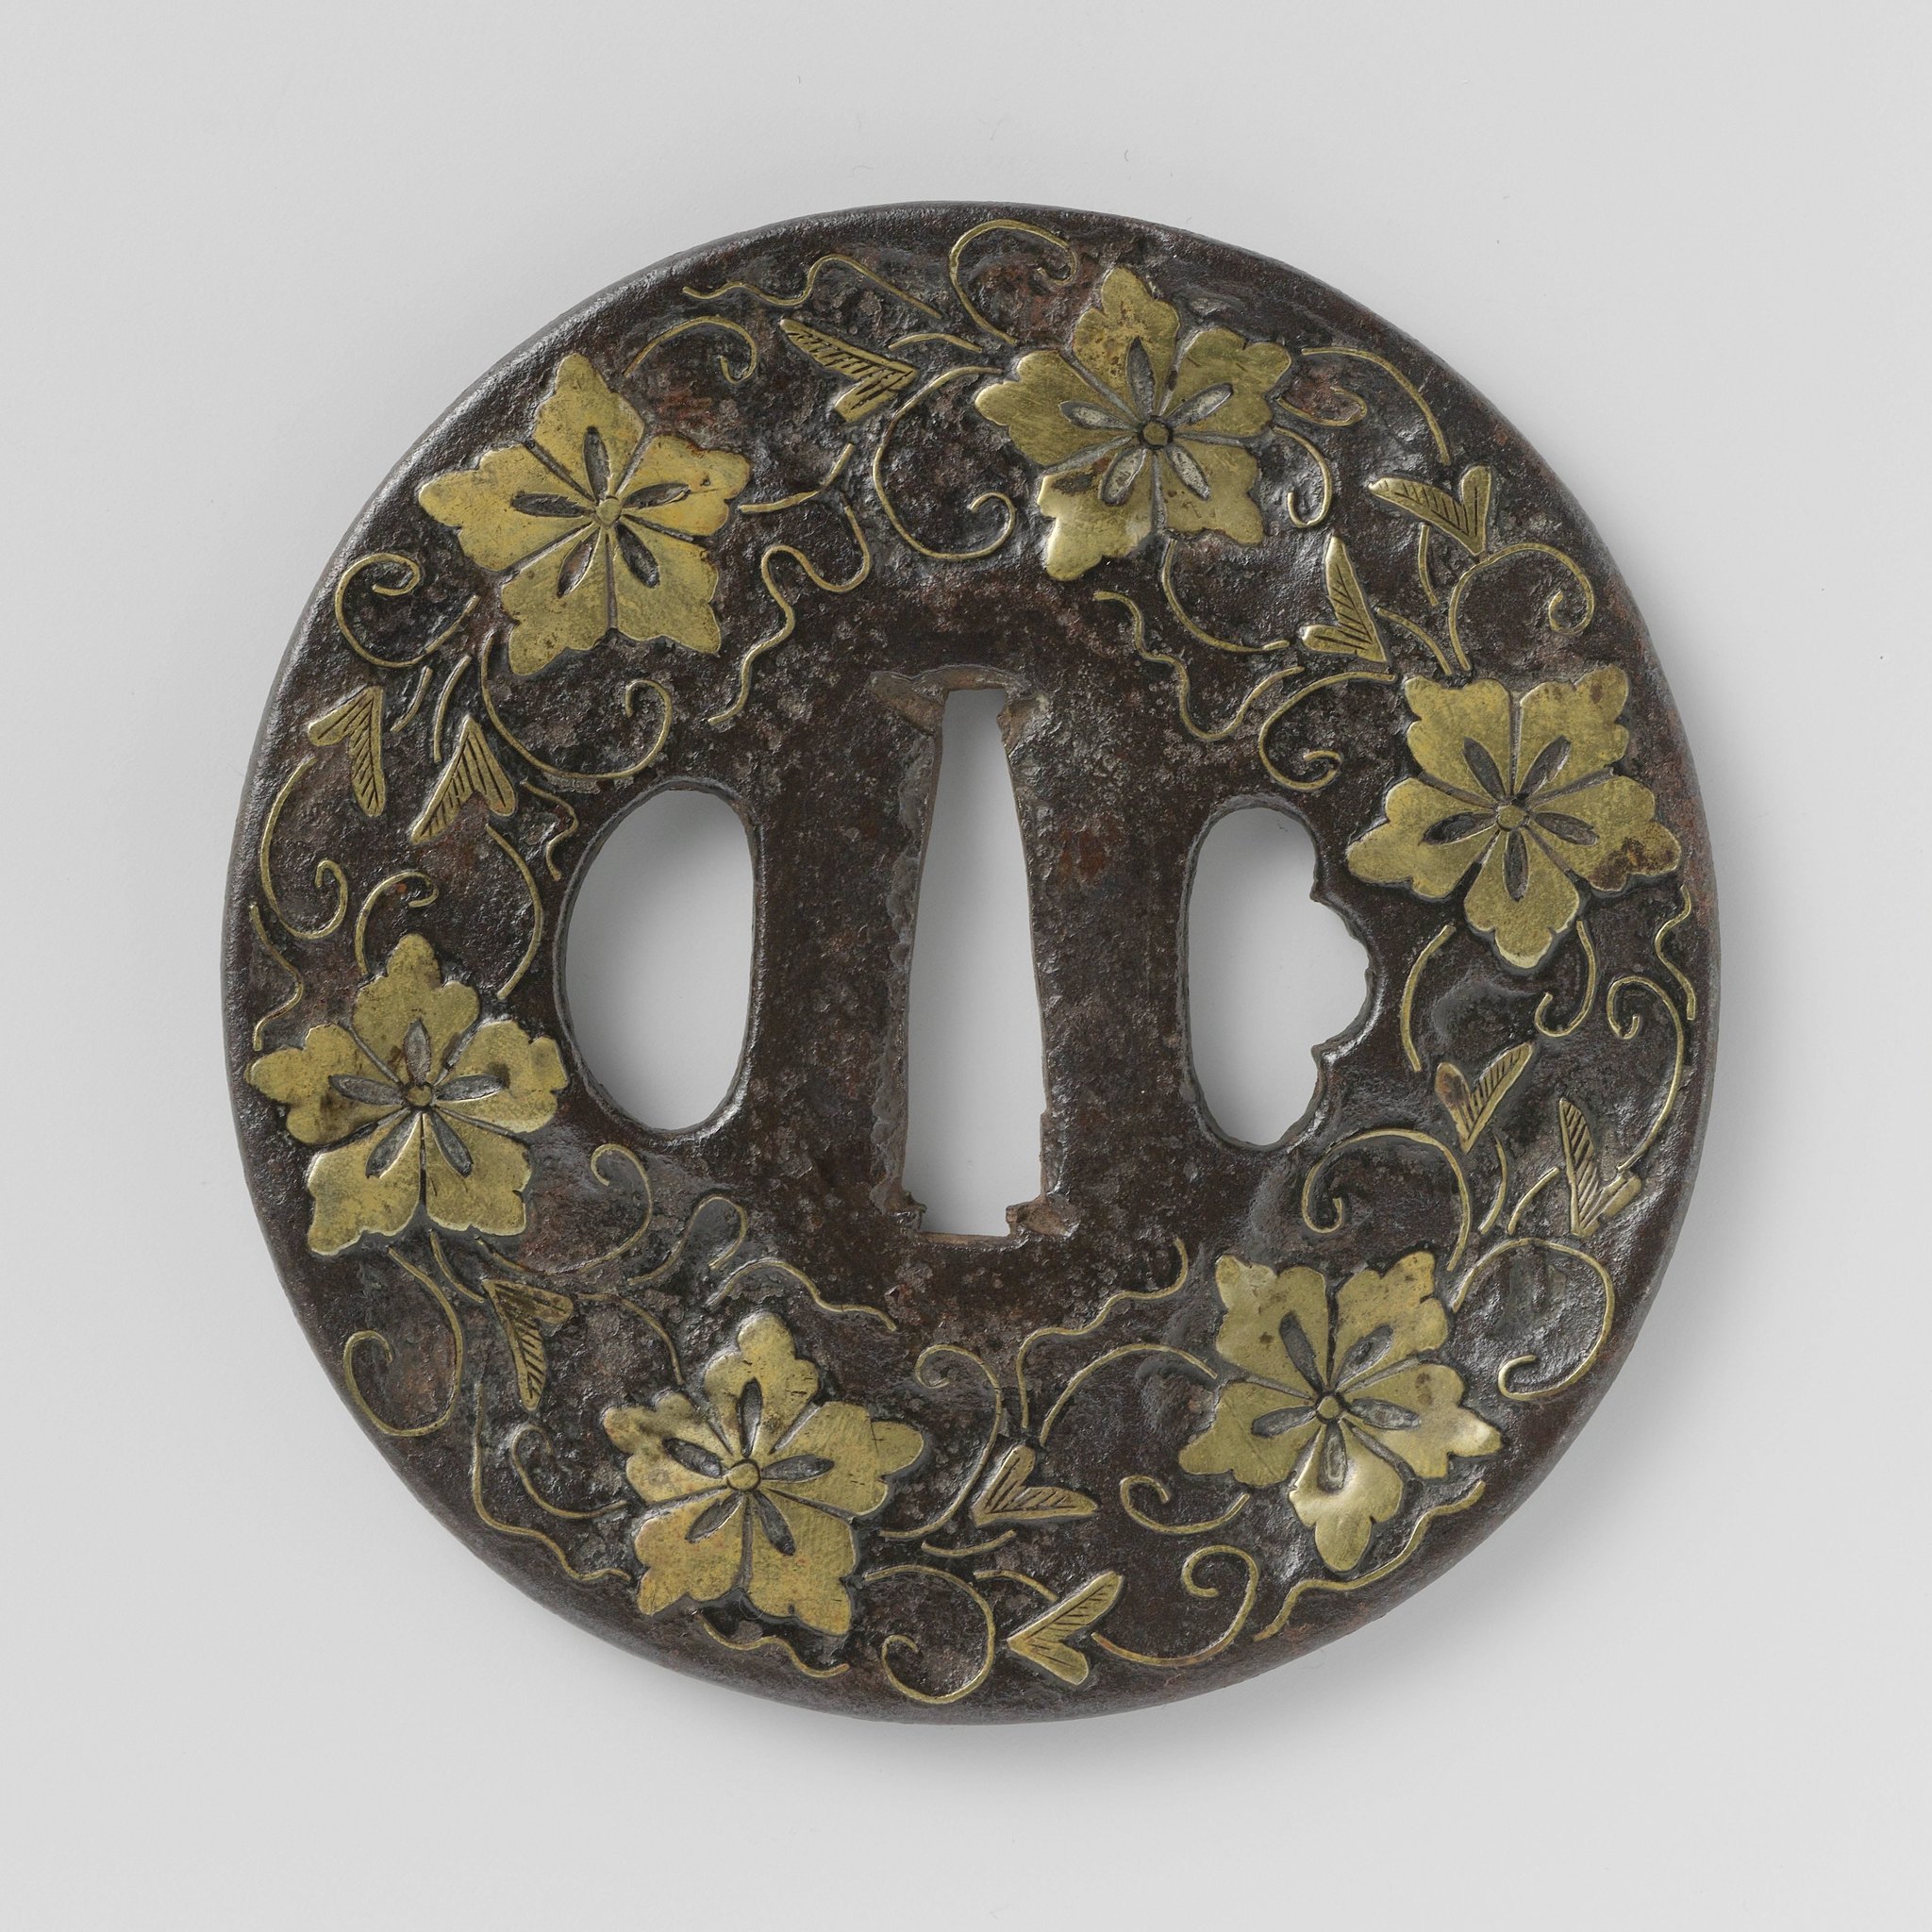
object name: tsuba, zwaardstootplaat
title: Hand guard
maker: Anonymous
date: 1600-1699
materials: bronze, iron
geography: japan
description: Bijna ronde tsuba; aan beide zijden in brons ingelegde bloemenranken op een zeer onregelmatige ondergrond.